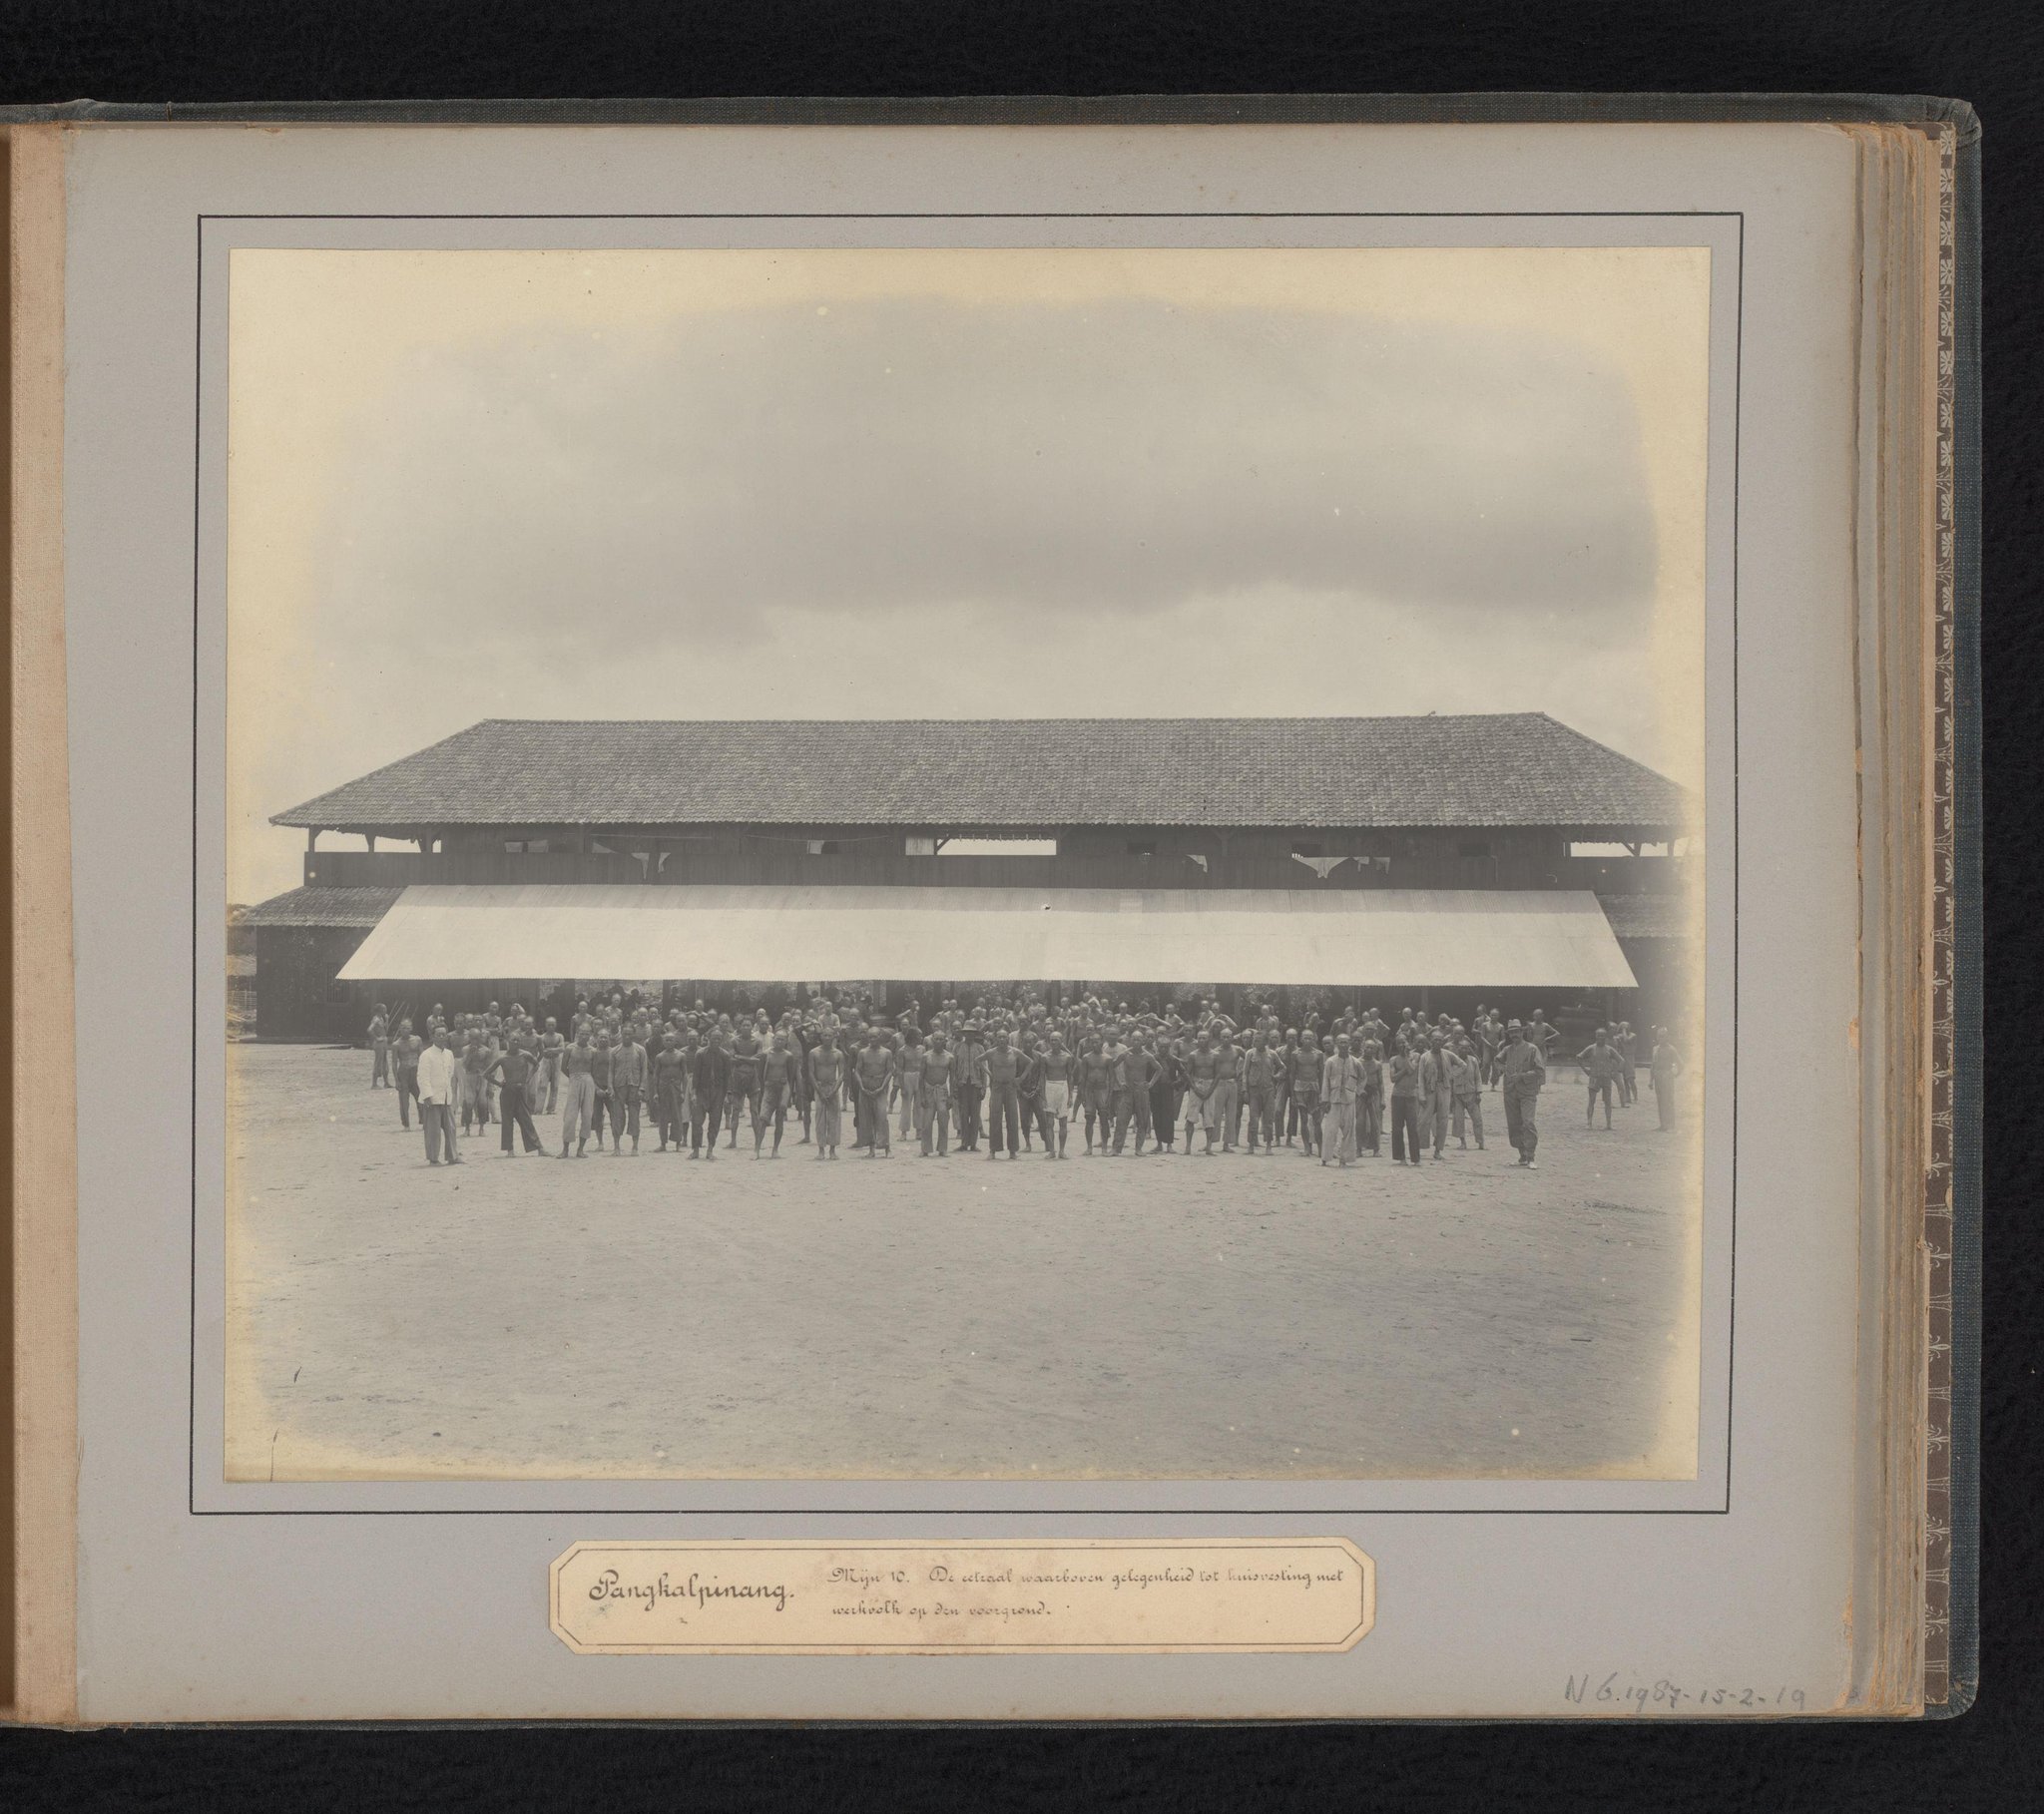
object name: photograph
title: Pangkalpinang. Mijn 10. De eetzaal waarboven gelegenheid tot huisvesting met werkvolk op den voorgrond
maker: Anonymous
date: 1907-1919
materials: cardboard, photographic support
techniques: gelatin silver print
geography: bangka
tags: robert julius boers, colonial system, minerals and metals: tin, working class, labourers, mine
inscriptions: label: ‘Pangkalpinang. Mijn 10. De eetzaal waarboven gelegenheid tot huisvesting met werkvolk op den voorgrond’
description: Een grote groep Chinese contractarbeiders poseert voor een eethuis bij een mijn van de Banka-tinwinning te Pangkalpinang. Onderdeel van het fotoalbum over de Banka-tinwinning, ca. 1907-1919.